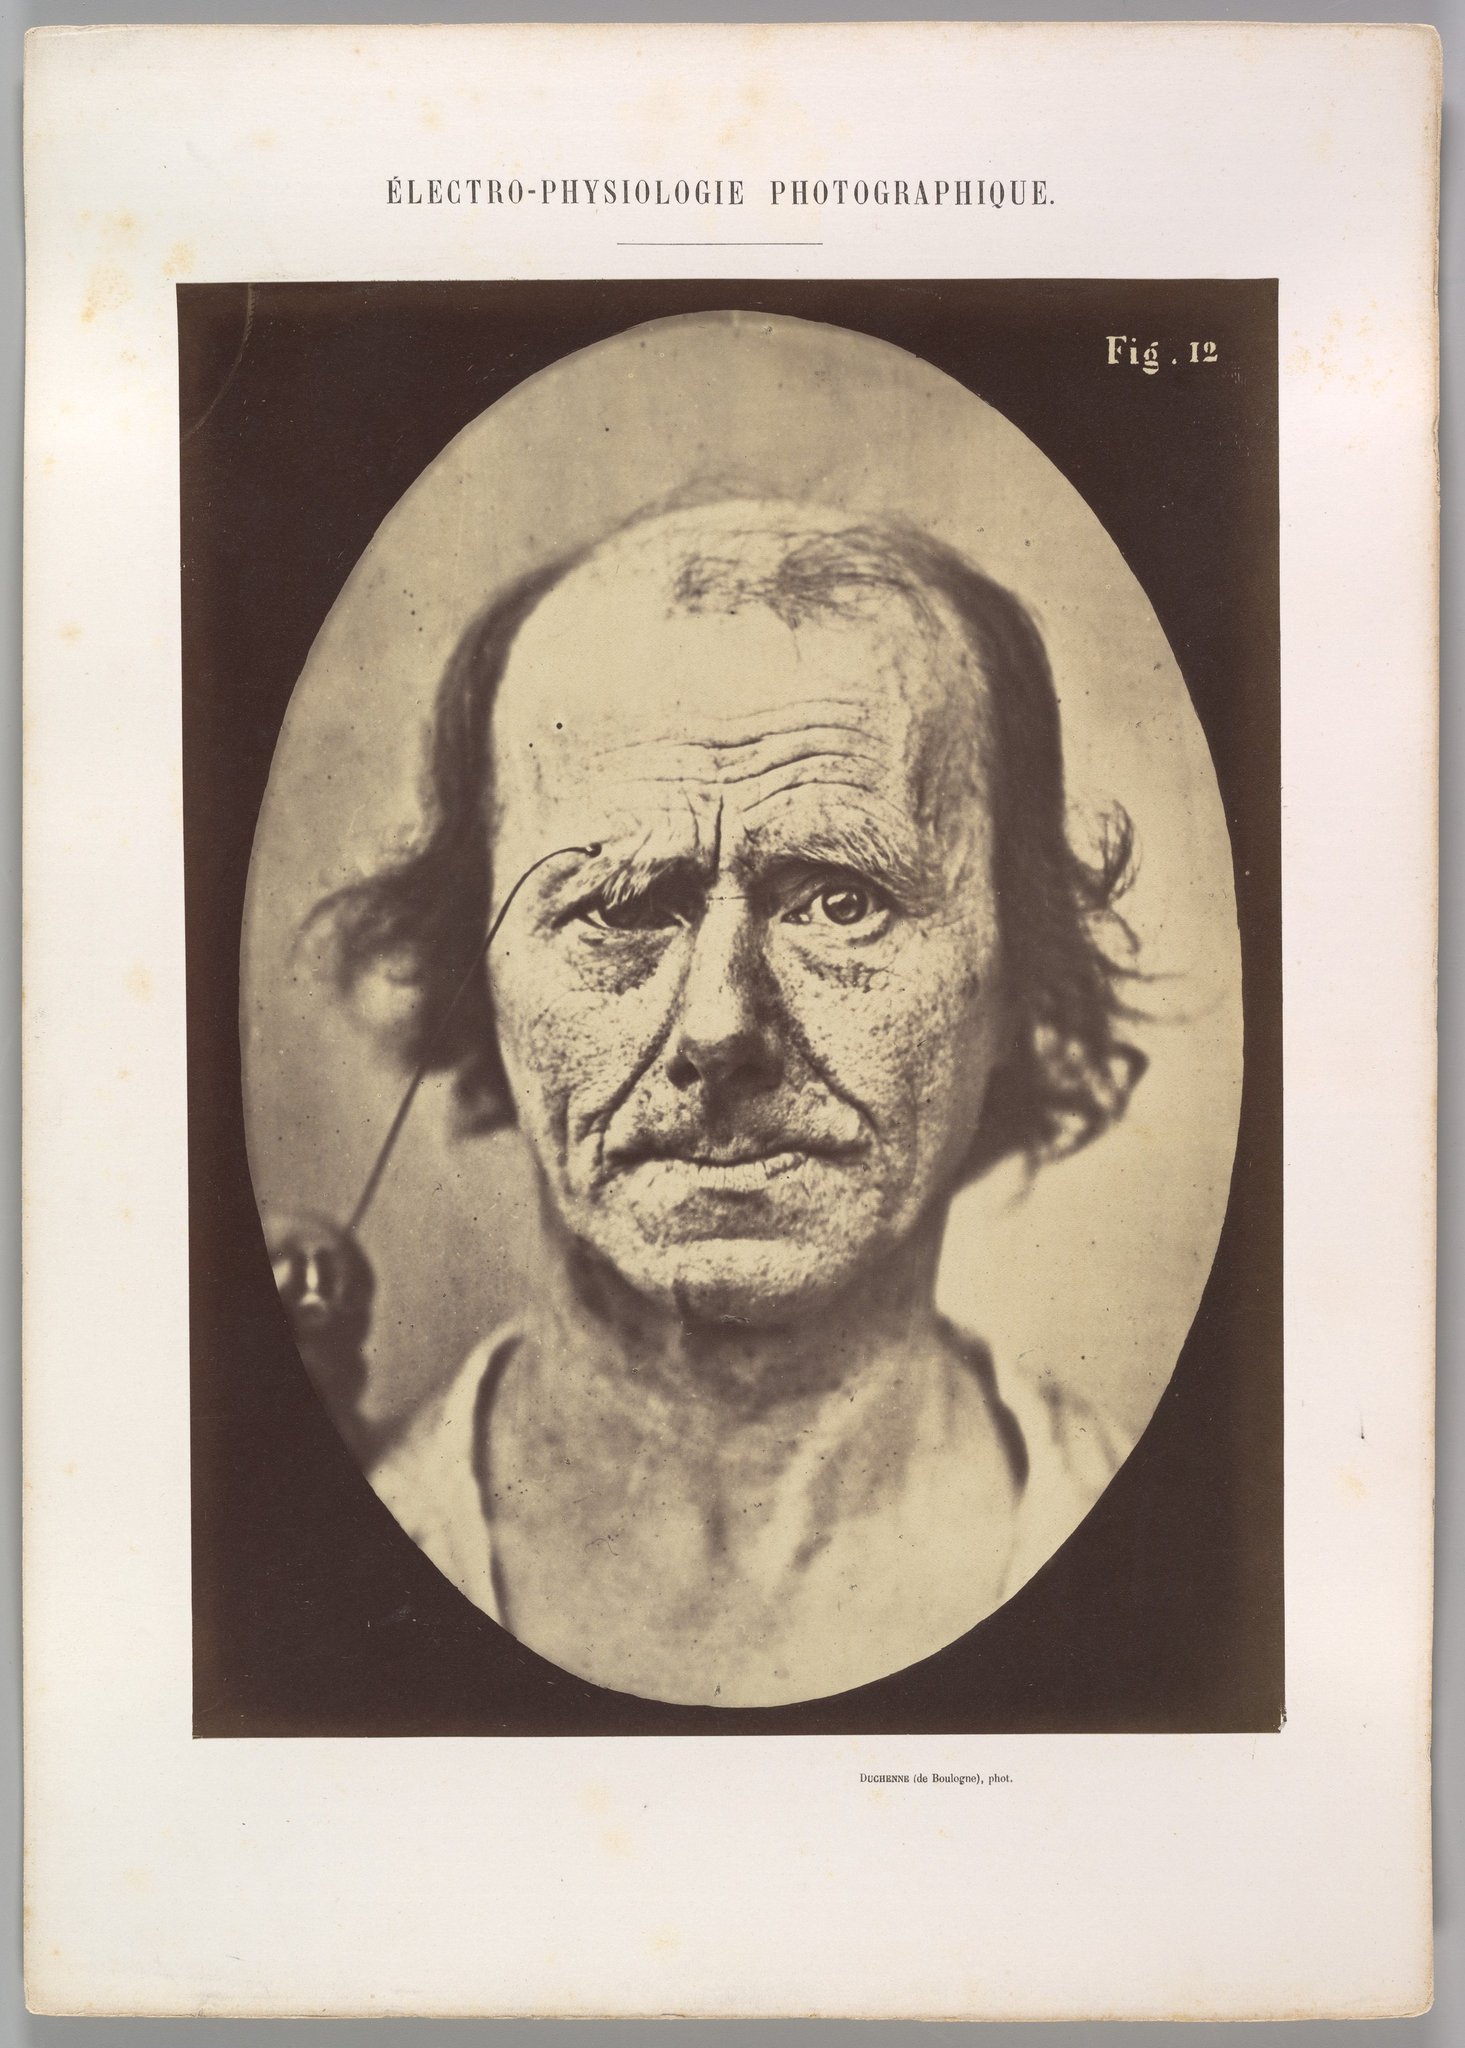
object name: photograph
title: Figure 12: A study of the contraction of and the expression produced by the superior part of m. orbicularis oculi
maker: guillaume-benjamin-amand duchenne de boulogne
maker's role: artist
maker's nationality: french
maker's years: 1806-1875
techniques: albumen silver print, glass negative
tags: science,men,portraits